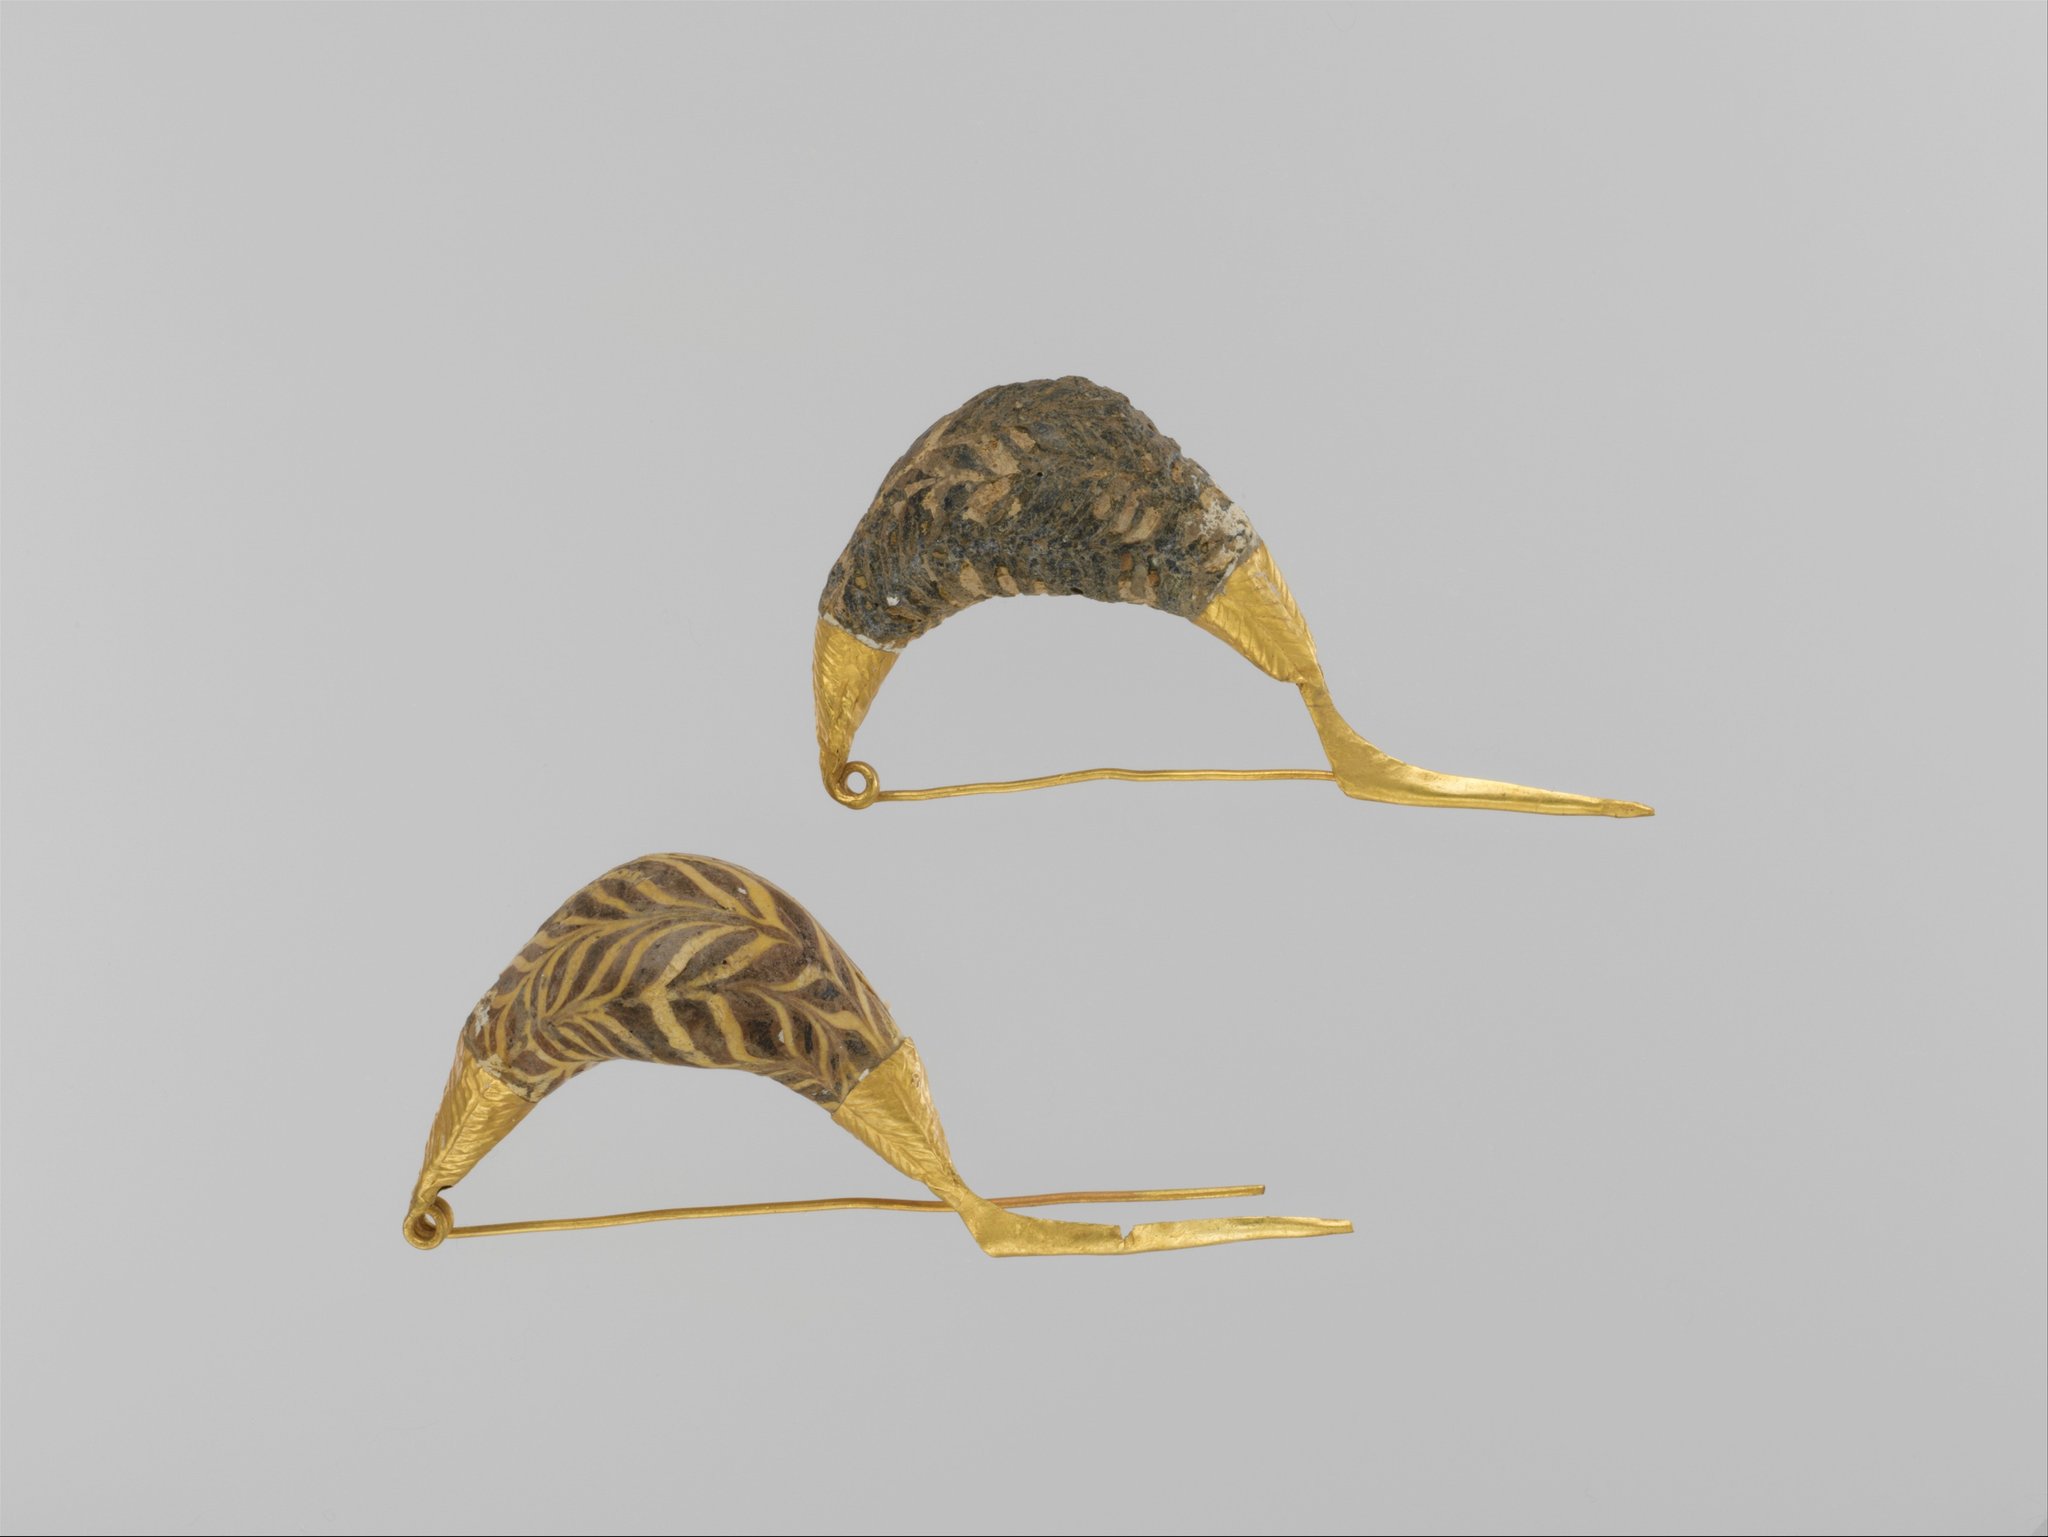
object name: fibula, sanguisuga type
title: Gold sanguisuga-type fibulae (safety pins) with glass paste bows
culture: etruscan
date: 734-668 BCE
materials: glass, gold